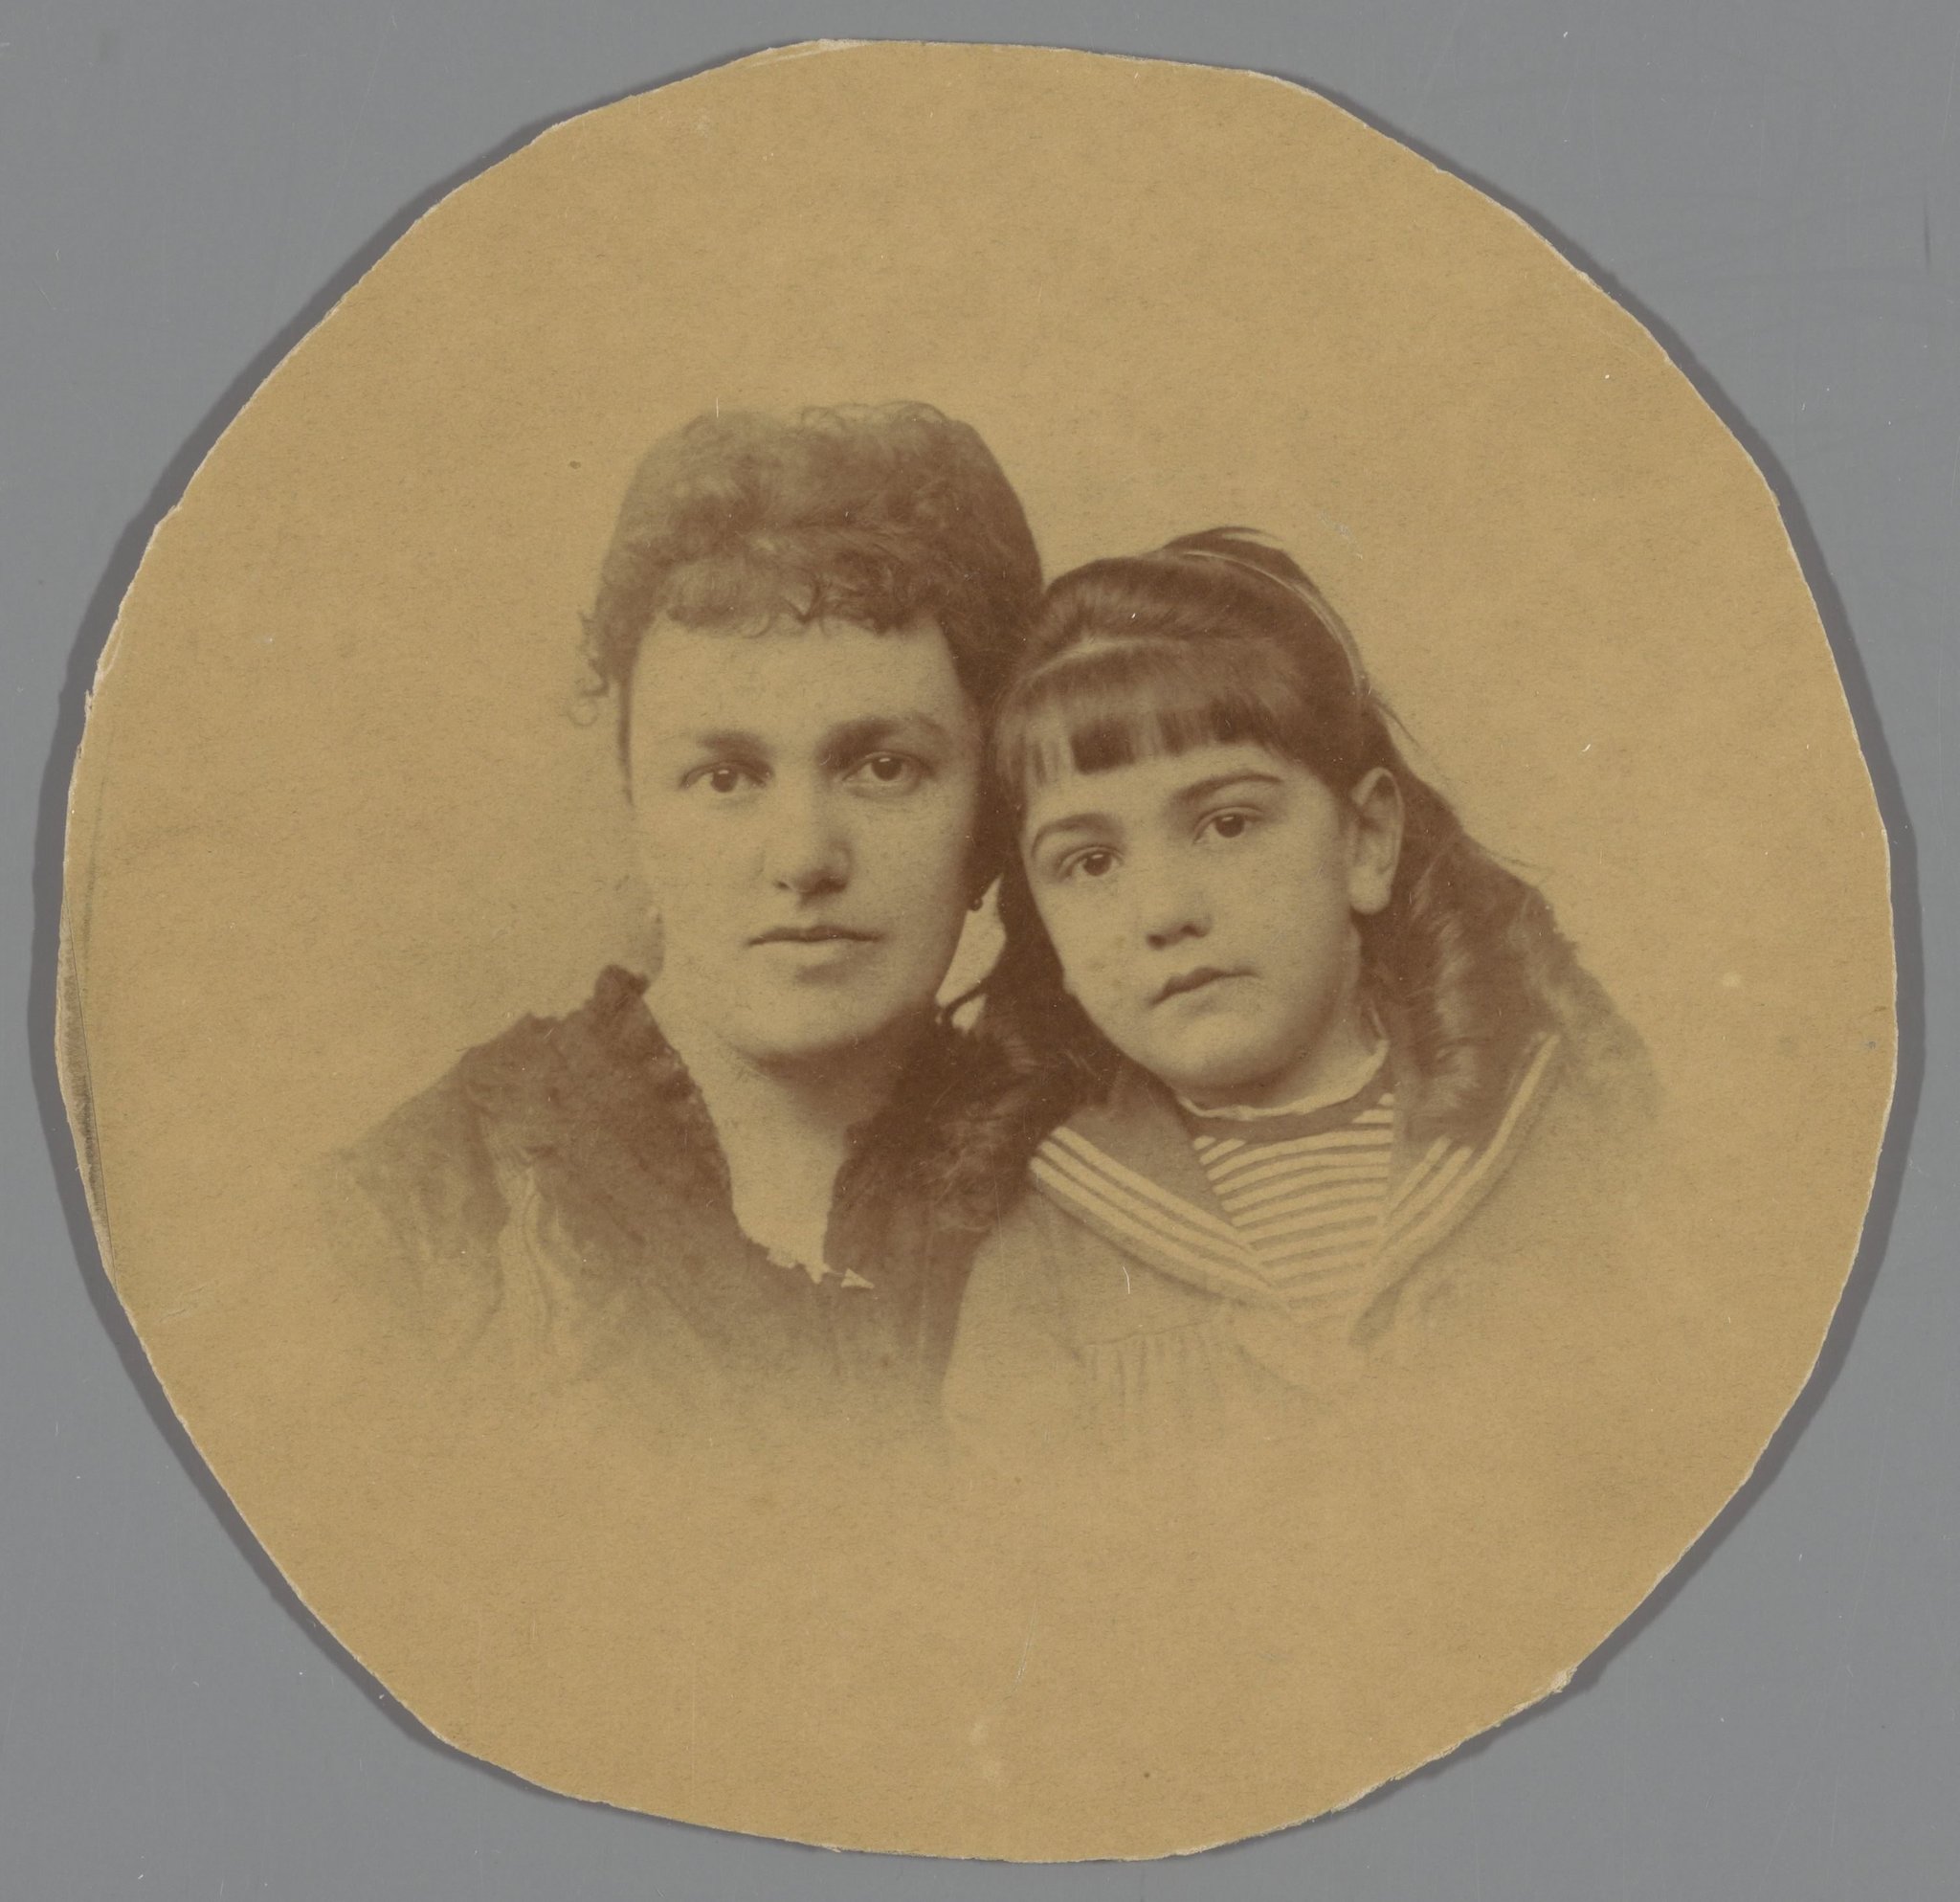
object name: photograph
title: Portret van Josine Marie Christine Grenfell met haar dochter Adeh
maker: Anonymous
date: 1884-1895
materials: cardboard, photographic support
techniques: albumen print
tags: arnhem, historical persons - bb - woman, mother and daughter(s) (family group)